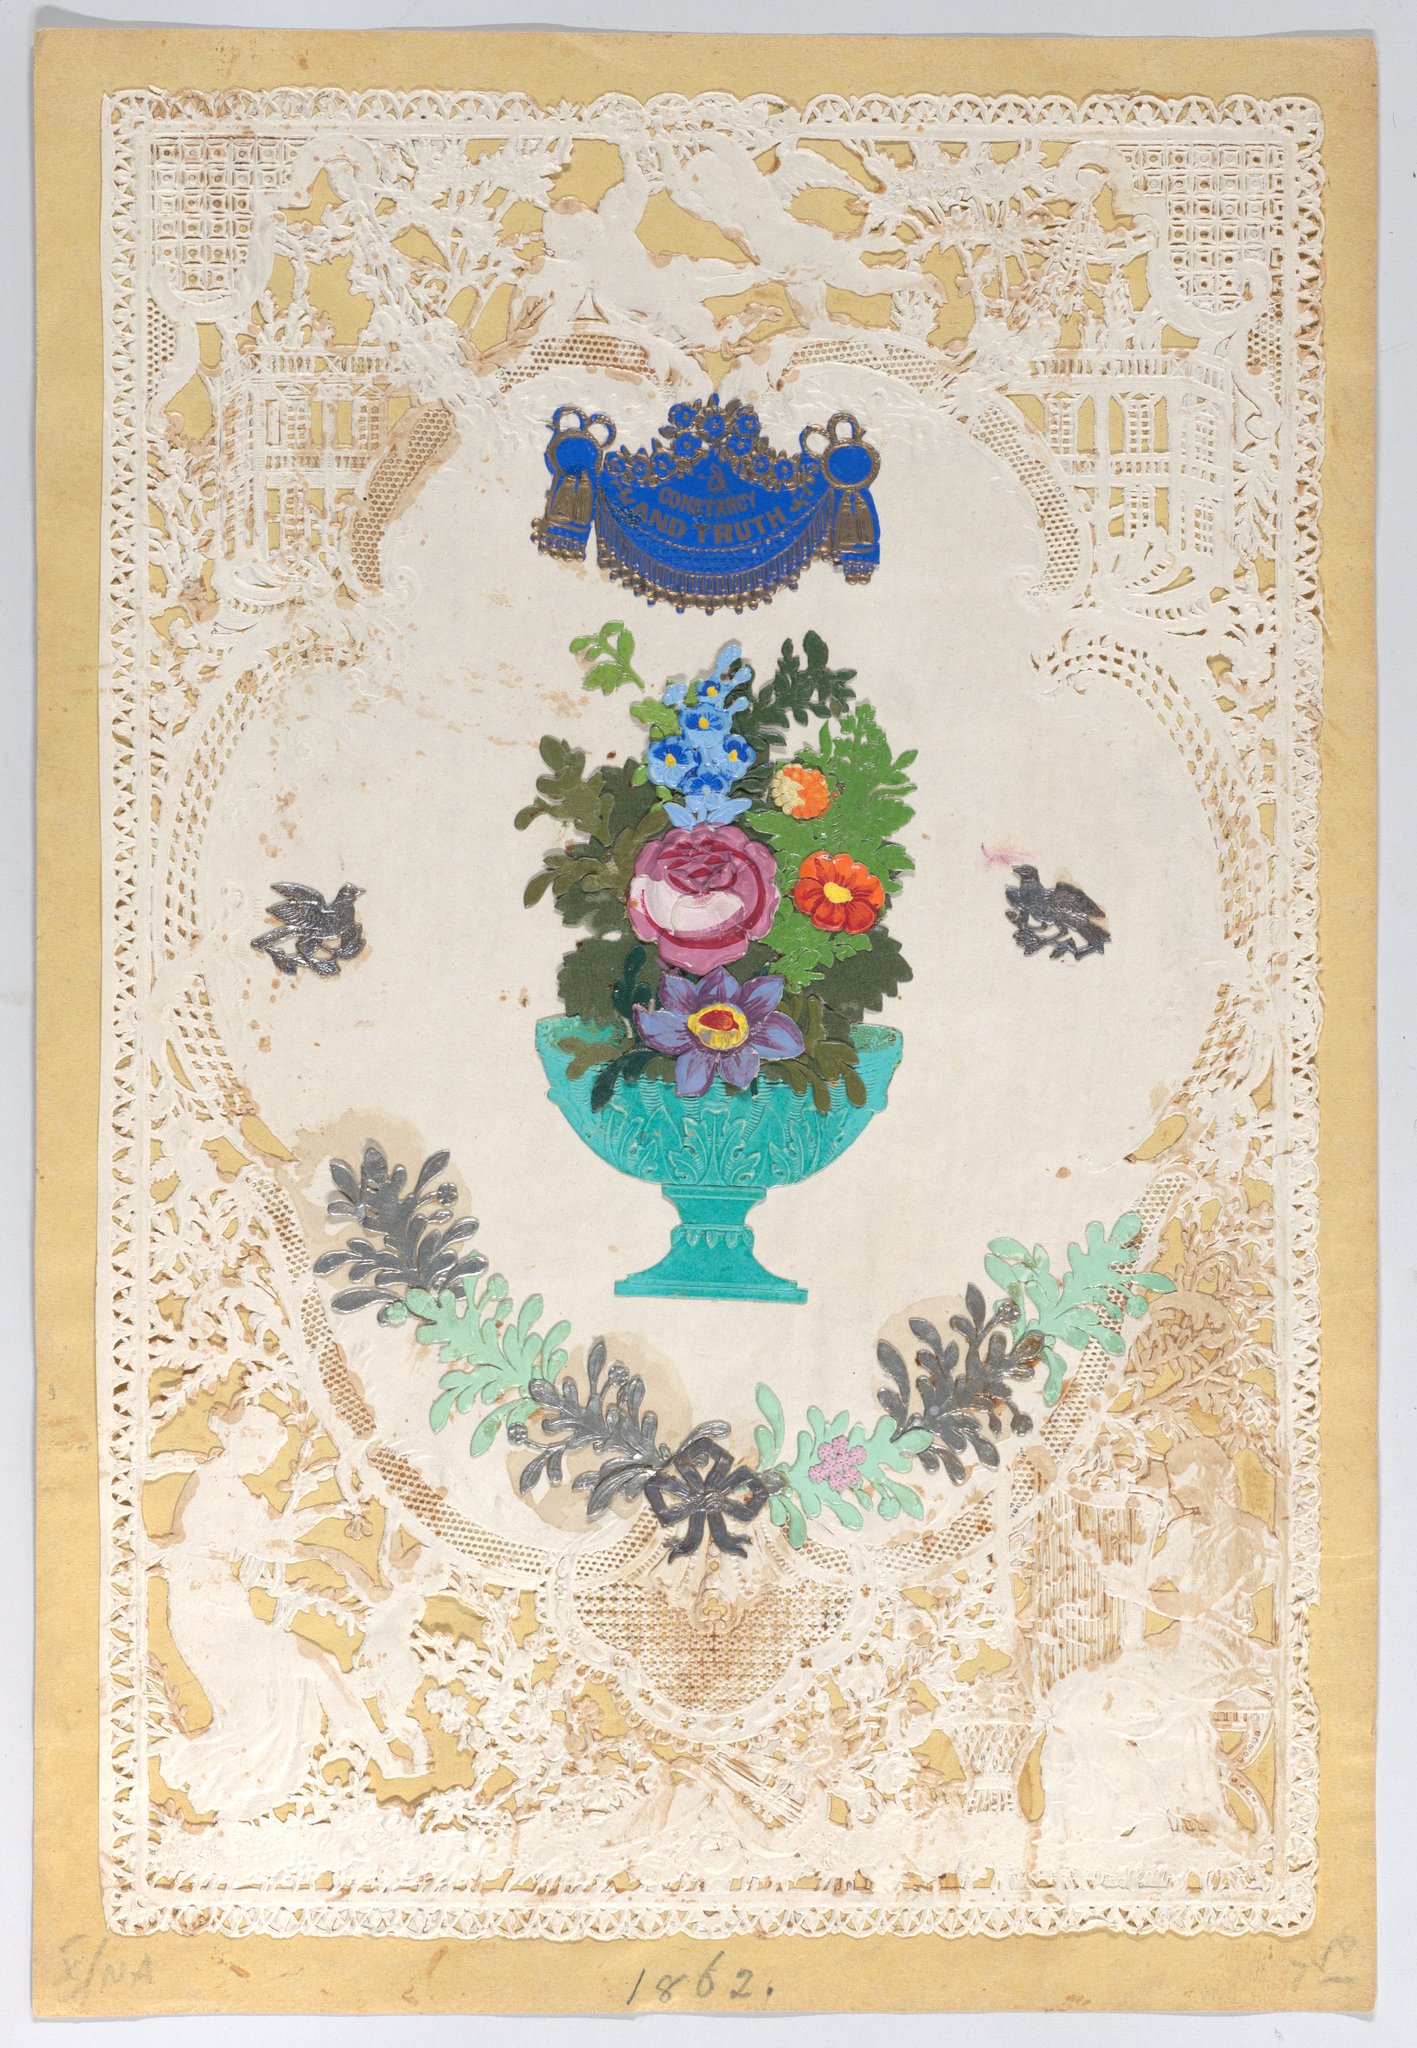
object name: valentine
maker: Anonymous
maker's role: artist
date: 1862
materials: gold, lace, paper, silver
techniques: embossing, open work, painting, printing